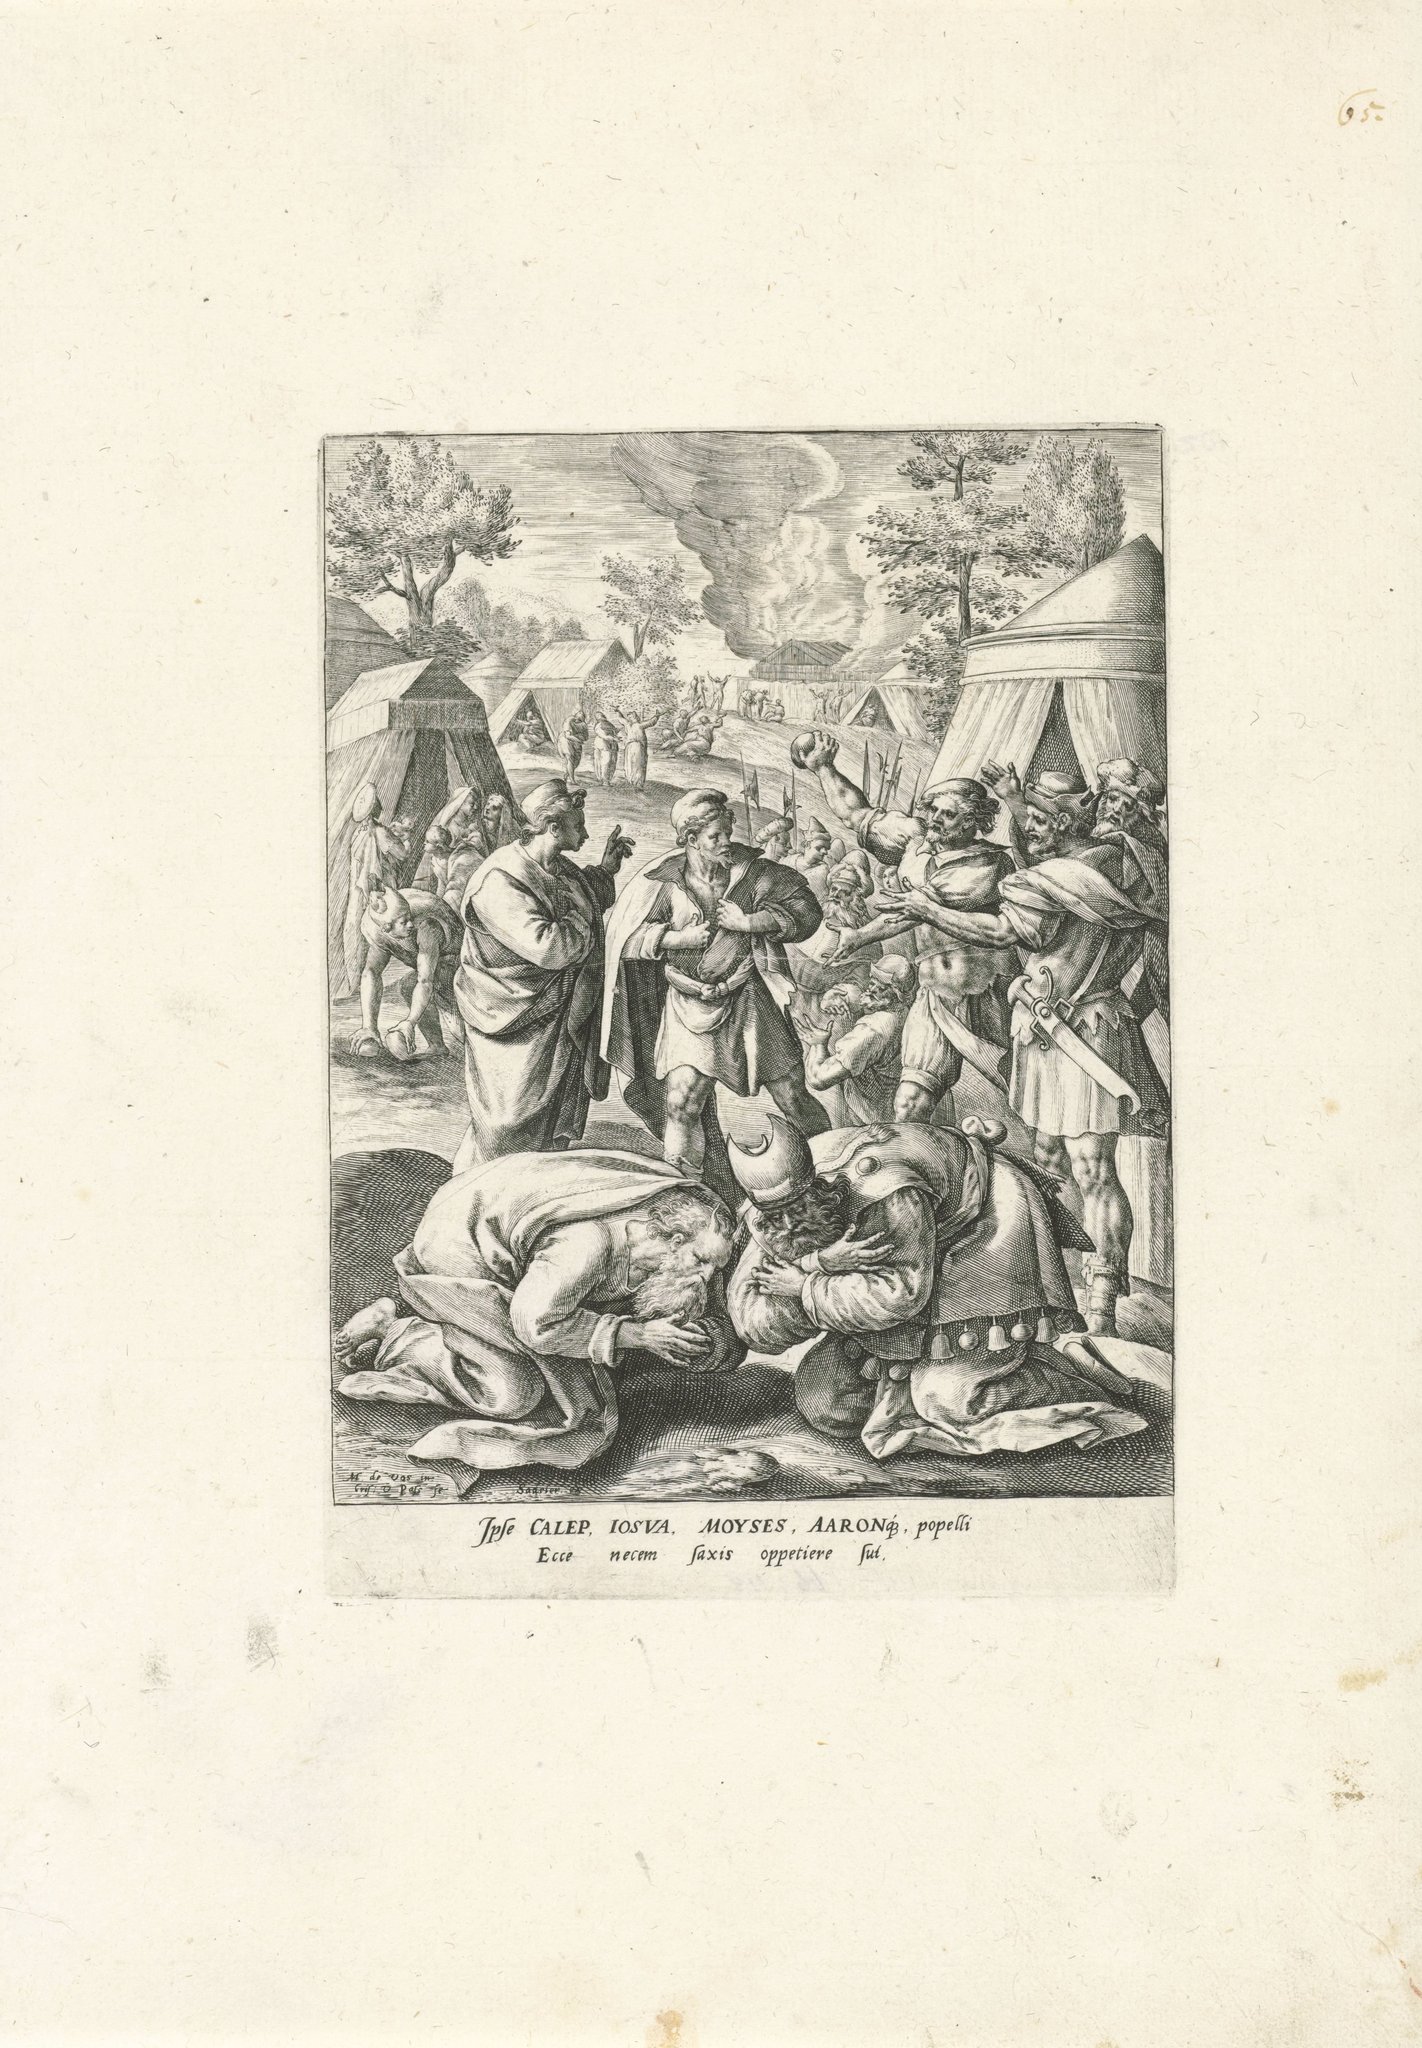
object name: print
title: Het volk van Israël dreigt Mozes, Aäron, Jozua en Kaleb te stenigen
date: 1591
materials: paper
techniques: engraving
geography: antwerp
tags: moses and aaron bow to the ground before the assembly, while joshua and caleb rend their clothes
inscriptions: collector's mark: Lugt 2228, inscription: ‘65.’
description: Mozes en Aäron werpen zich ter aarde terwijl Jozua en Kaleb hun kleren scheuren. Ze vertelden het volk dat zij vertrouwen moesten hebben in God waarop het volk hen dreigt te stenigen. Op de achtergrond de ontmoetingstent van de Israëlieten. In de marge een tweeregelig onderschrift in het Latijn.